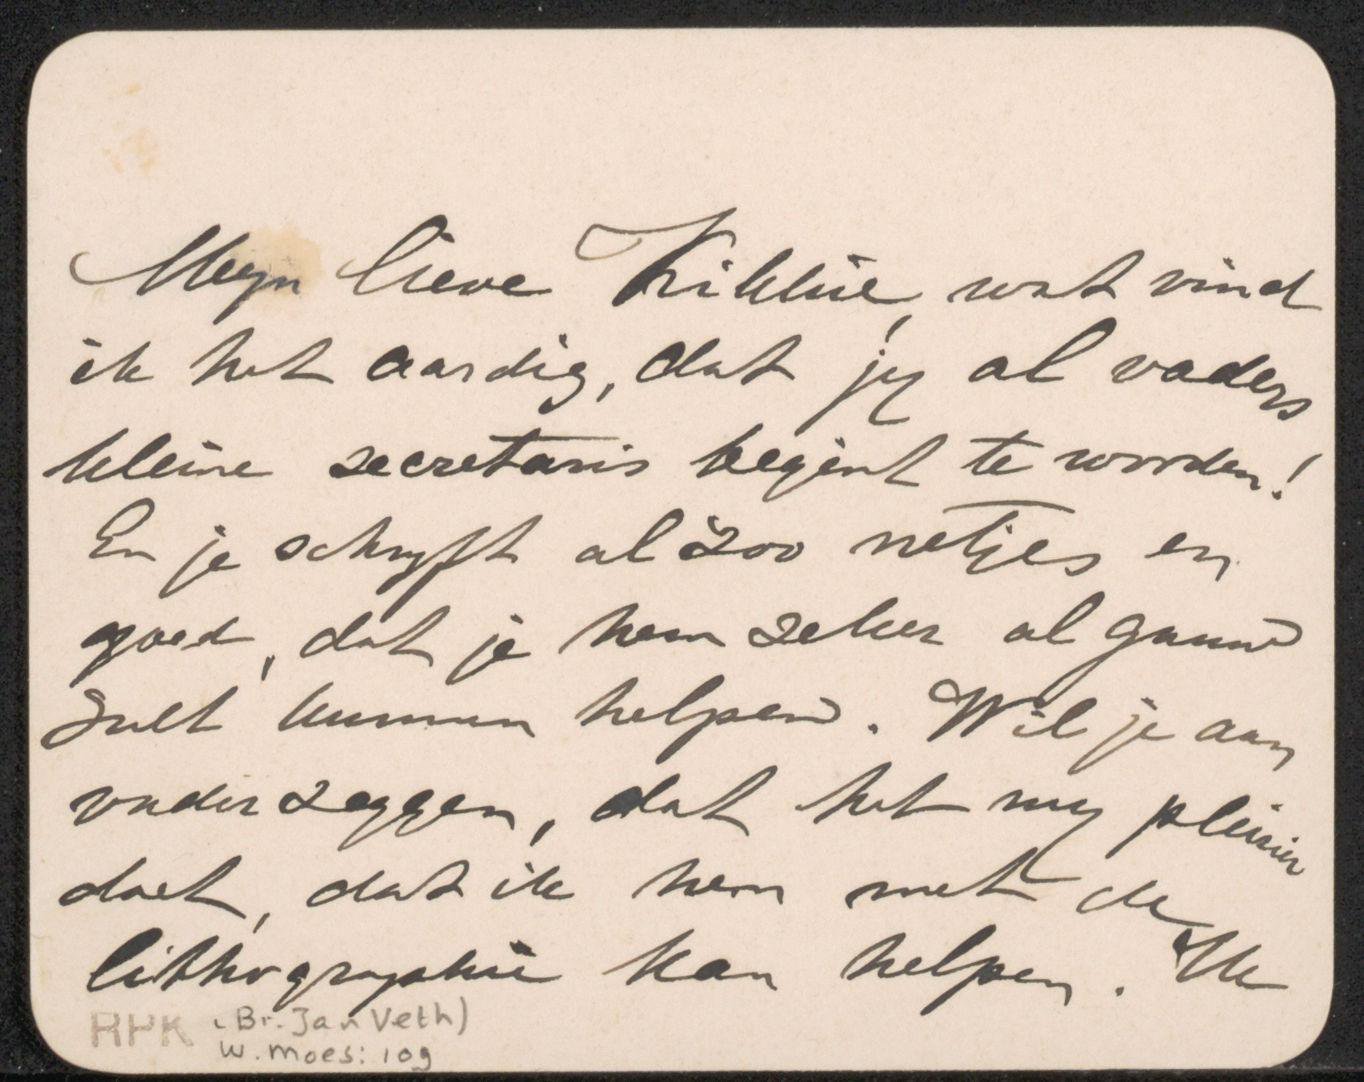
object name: letter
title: Brief aan Alida Johanna Veth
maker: wally moes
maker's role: draughtsman, print maker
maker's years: 1856-1918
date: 1901-1918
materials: ink, paper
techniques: pen, writing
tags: painter, designer, jan veth, the graphic arts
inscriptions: collector's mark: ‘RPK’